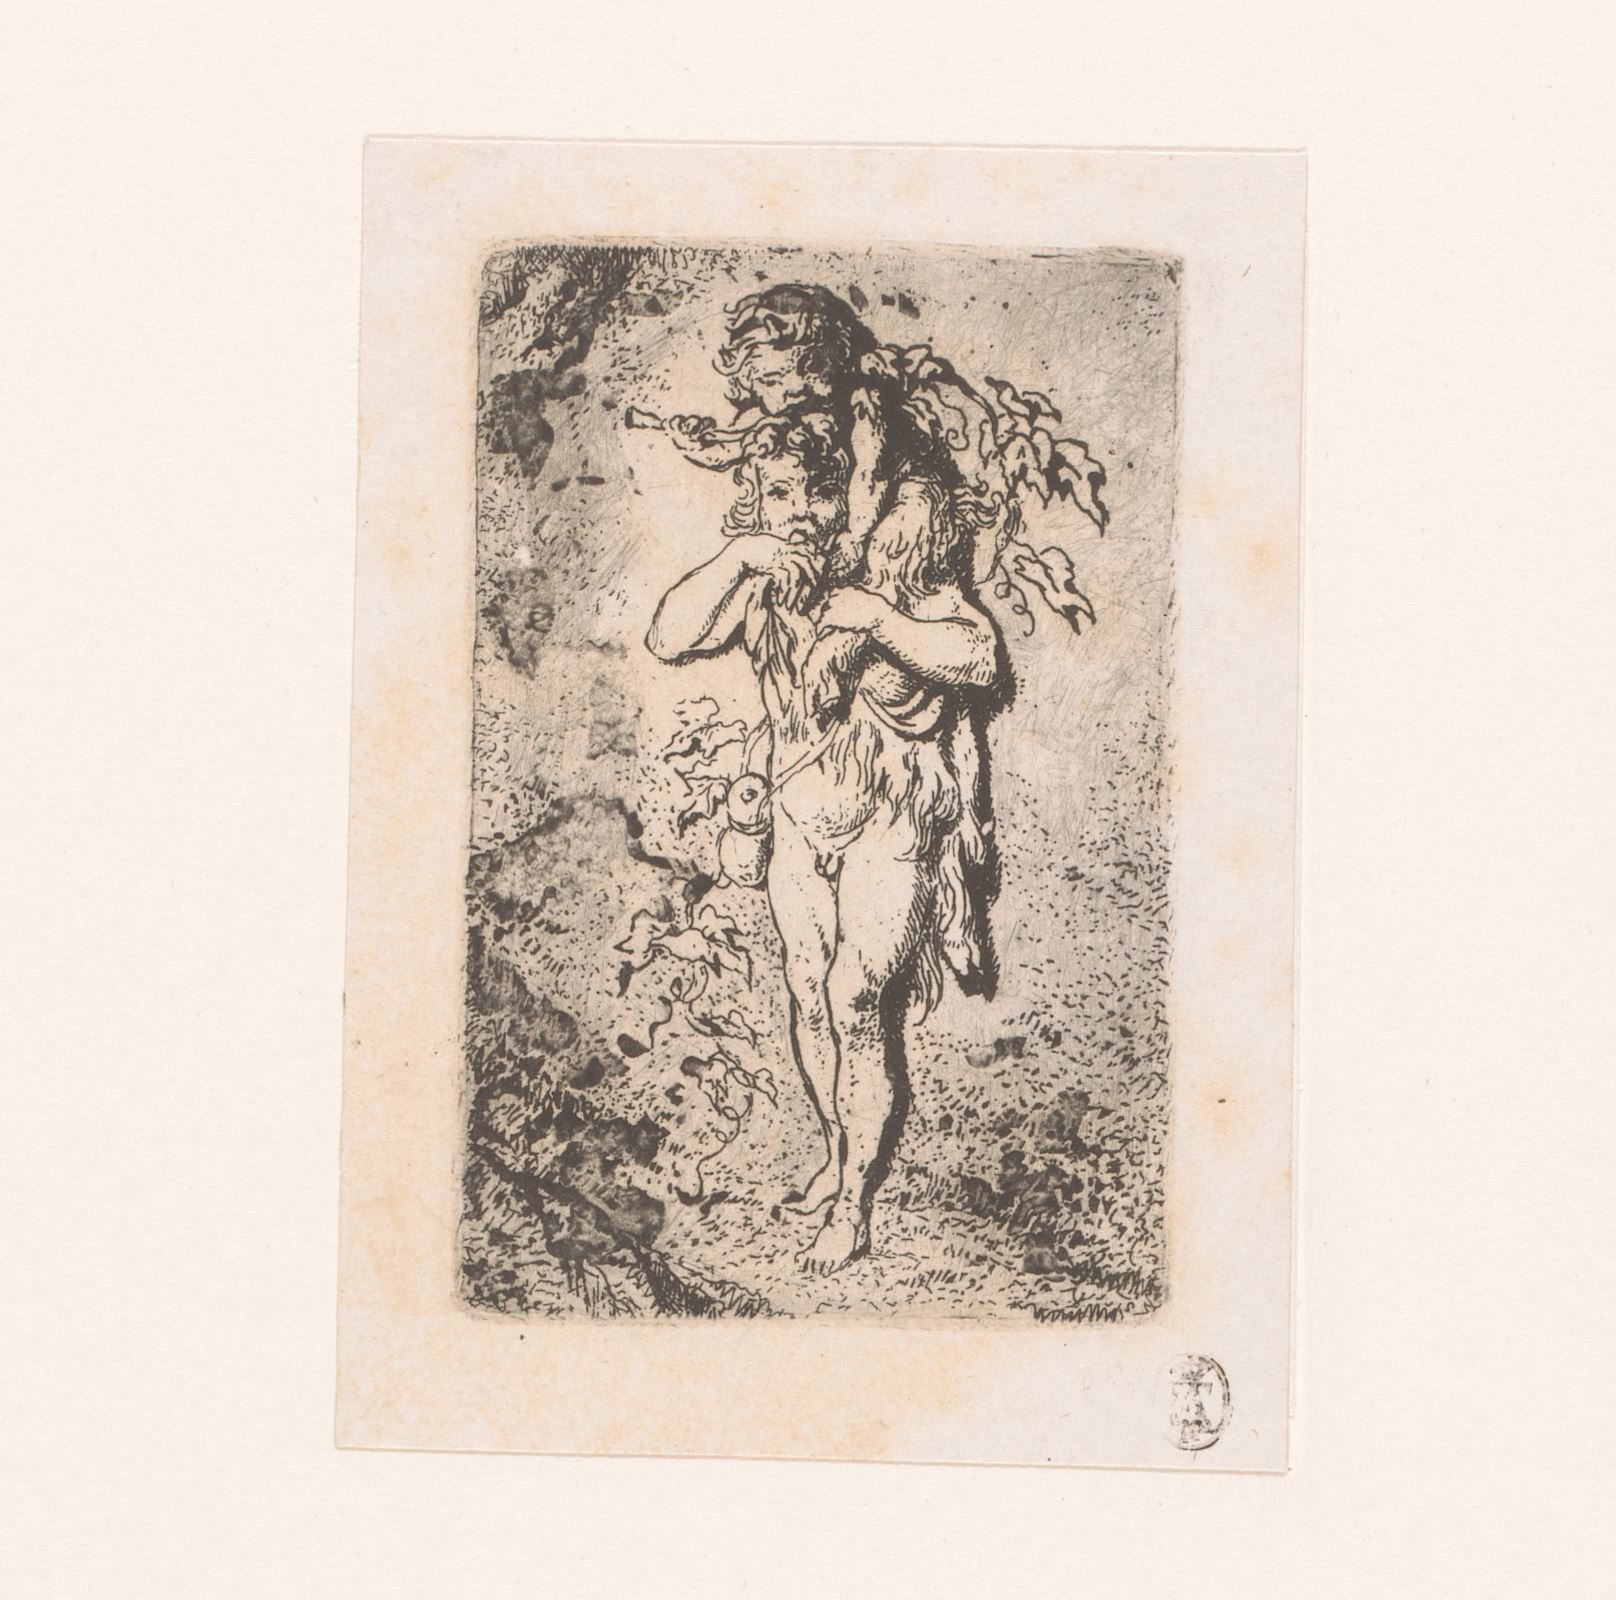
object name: print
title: Jongen met faun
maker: friedrich müller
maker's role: painter, print maker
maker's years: 1749-1825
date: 1774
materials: paper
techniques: etching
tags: satyr(s) (in general)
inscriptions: collector's mark: Lugt 2228, collector's mark: Lugt 2760, collector's mark: Lugt 971